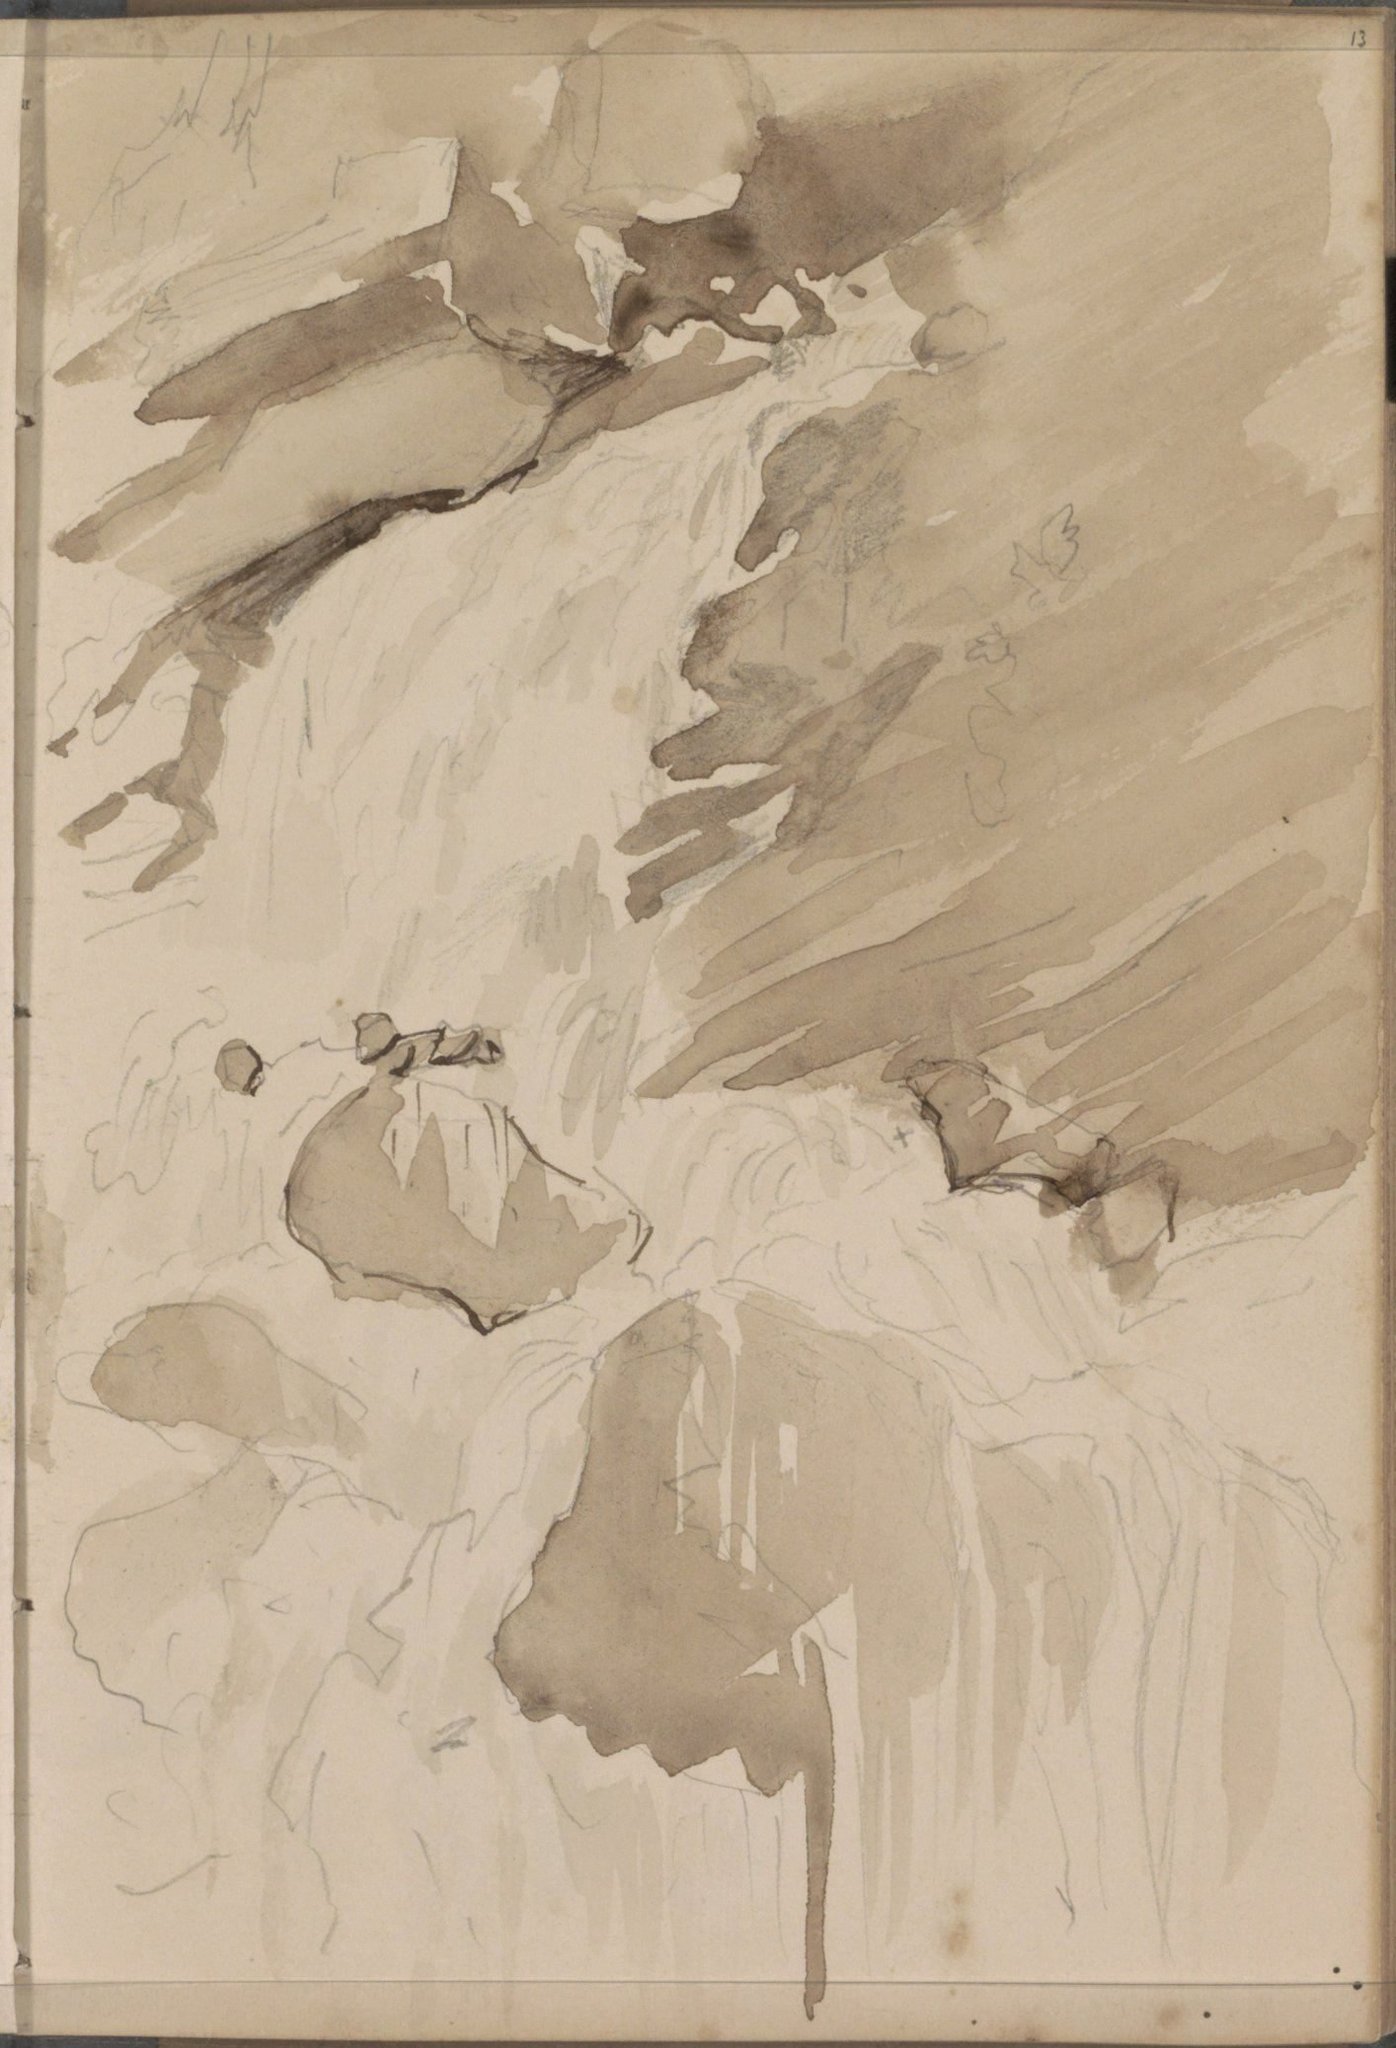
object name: sketchbook leaf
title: Waterval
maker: johannes tavenraat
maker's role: draughtsman, painter, print maker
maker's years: 1809-1881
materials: ink, paper, pencil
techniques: brush, pen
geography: basel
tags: waterfall, rocks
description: Blad 13 recto uit een schetsboek met 47 bladen.